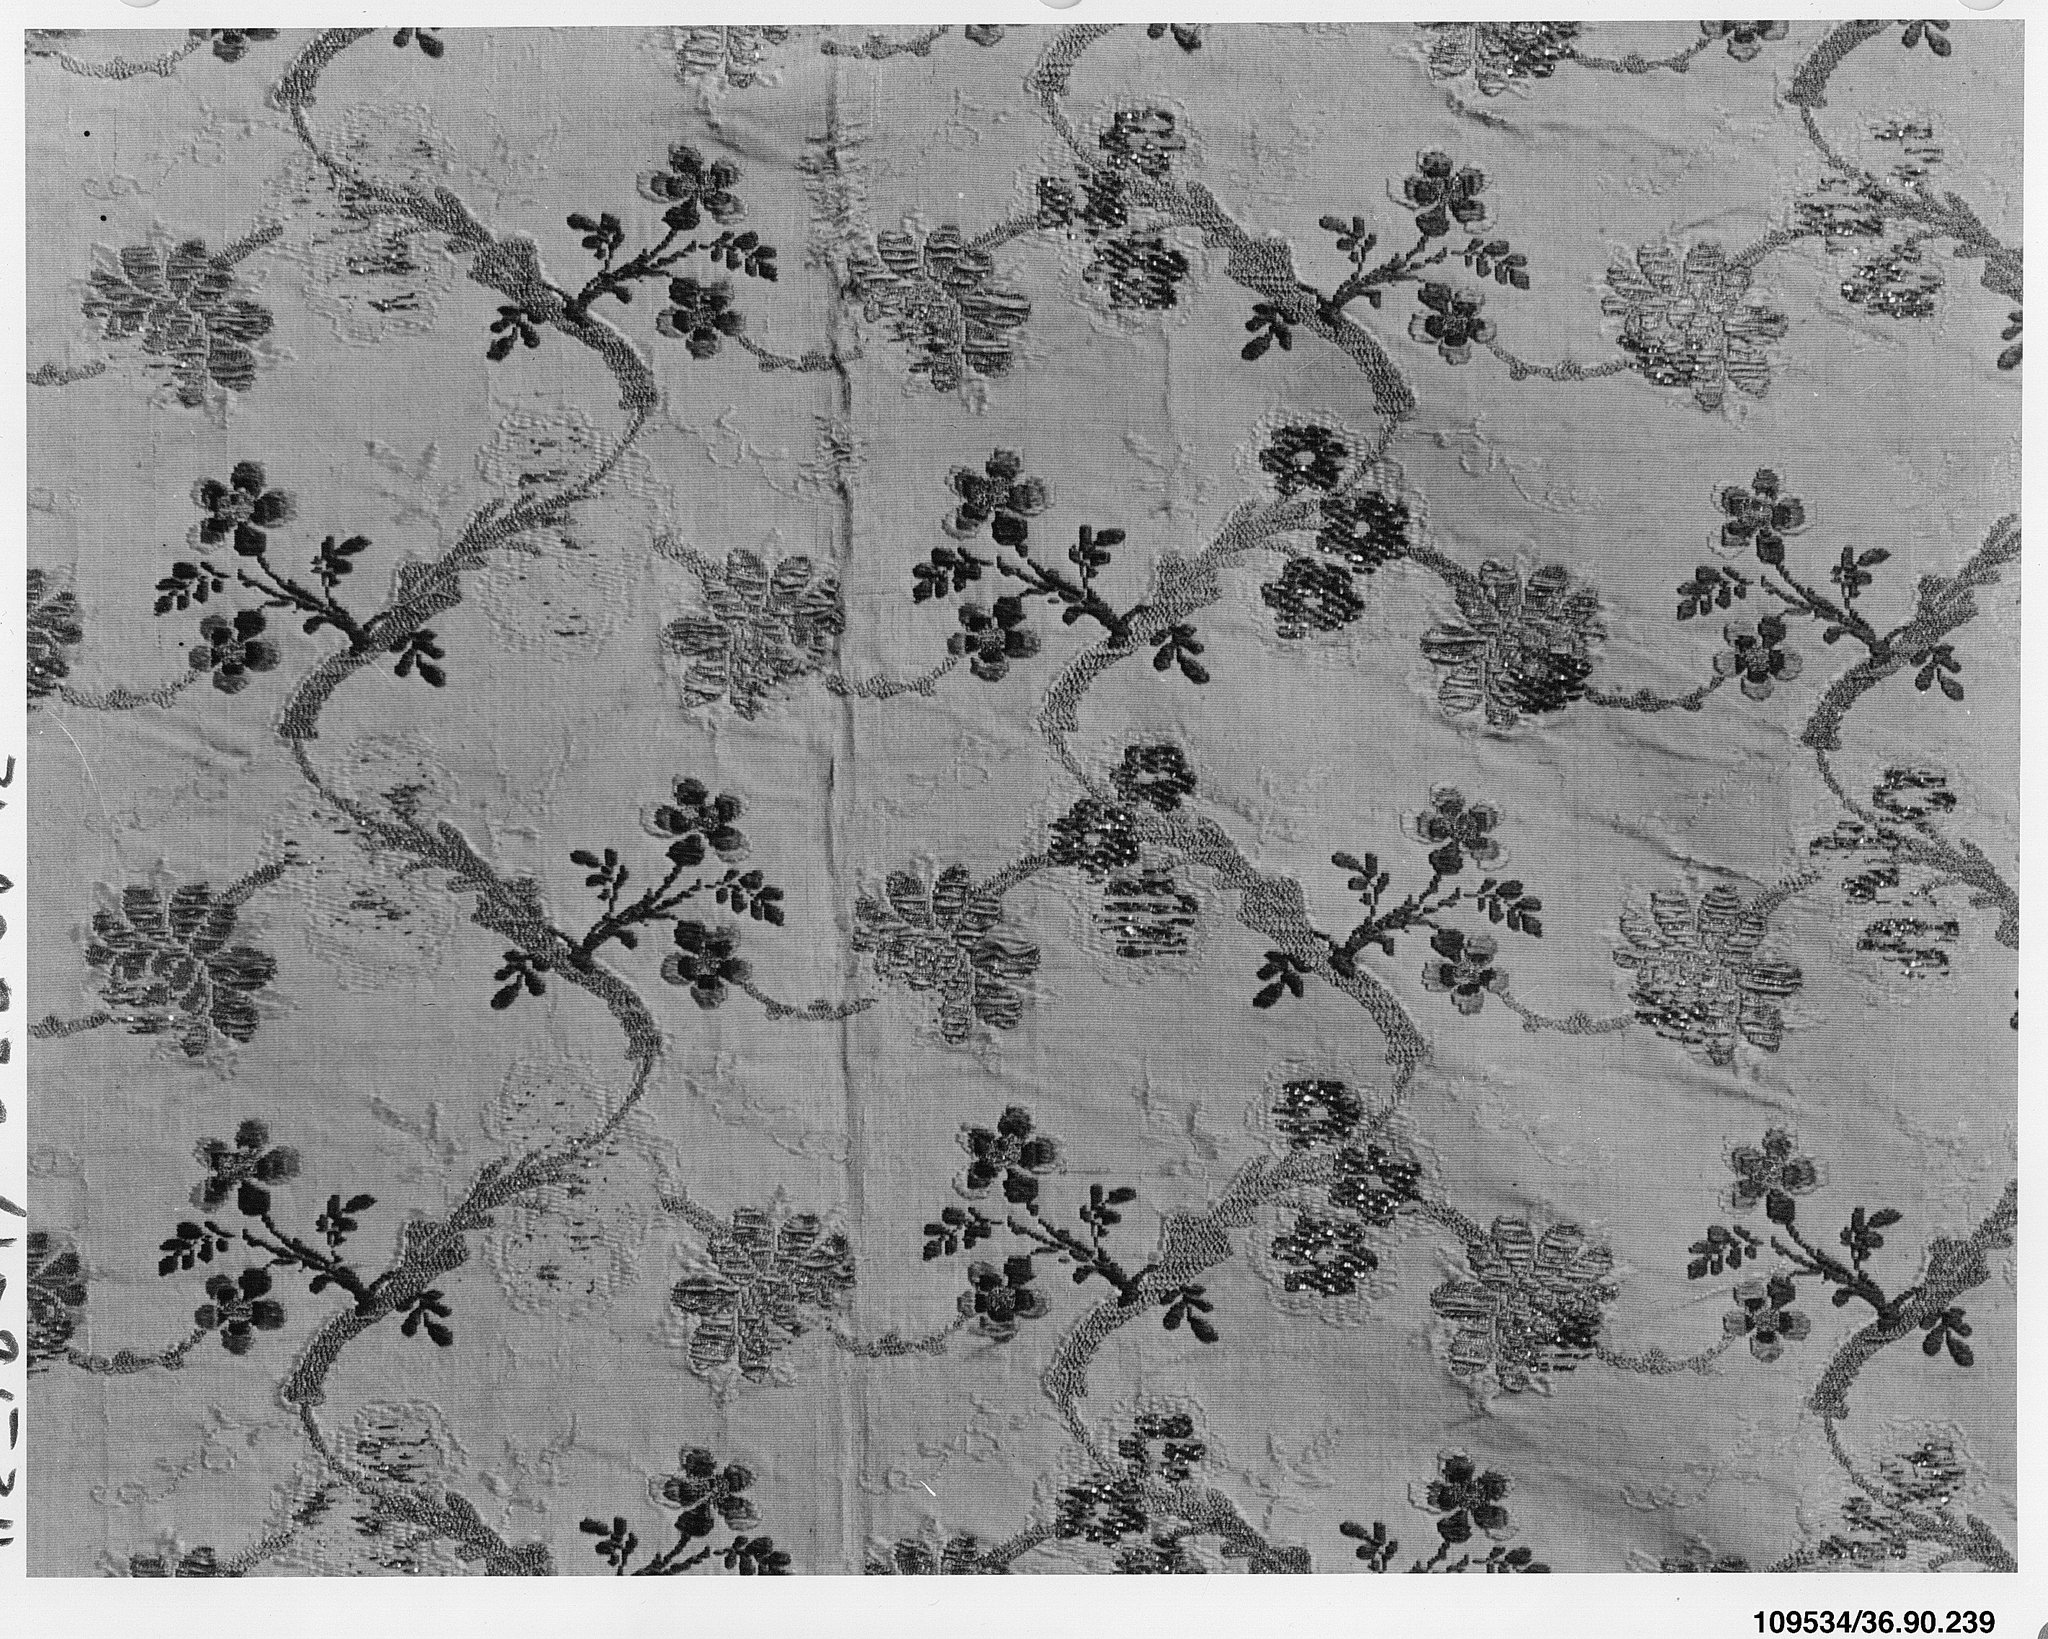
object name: piece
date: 1760-1770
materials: metal thread, silk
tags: flowers